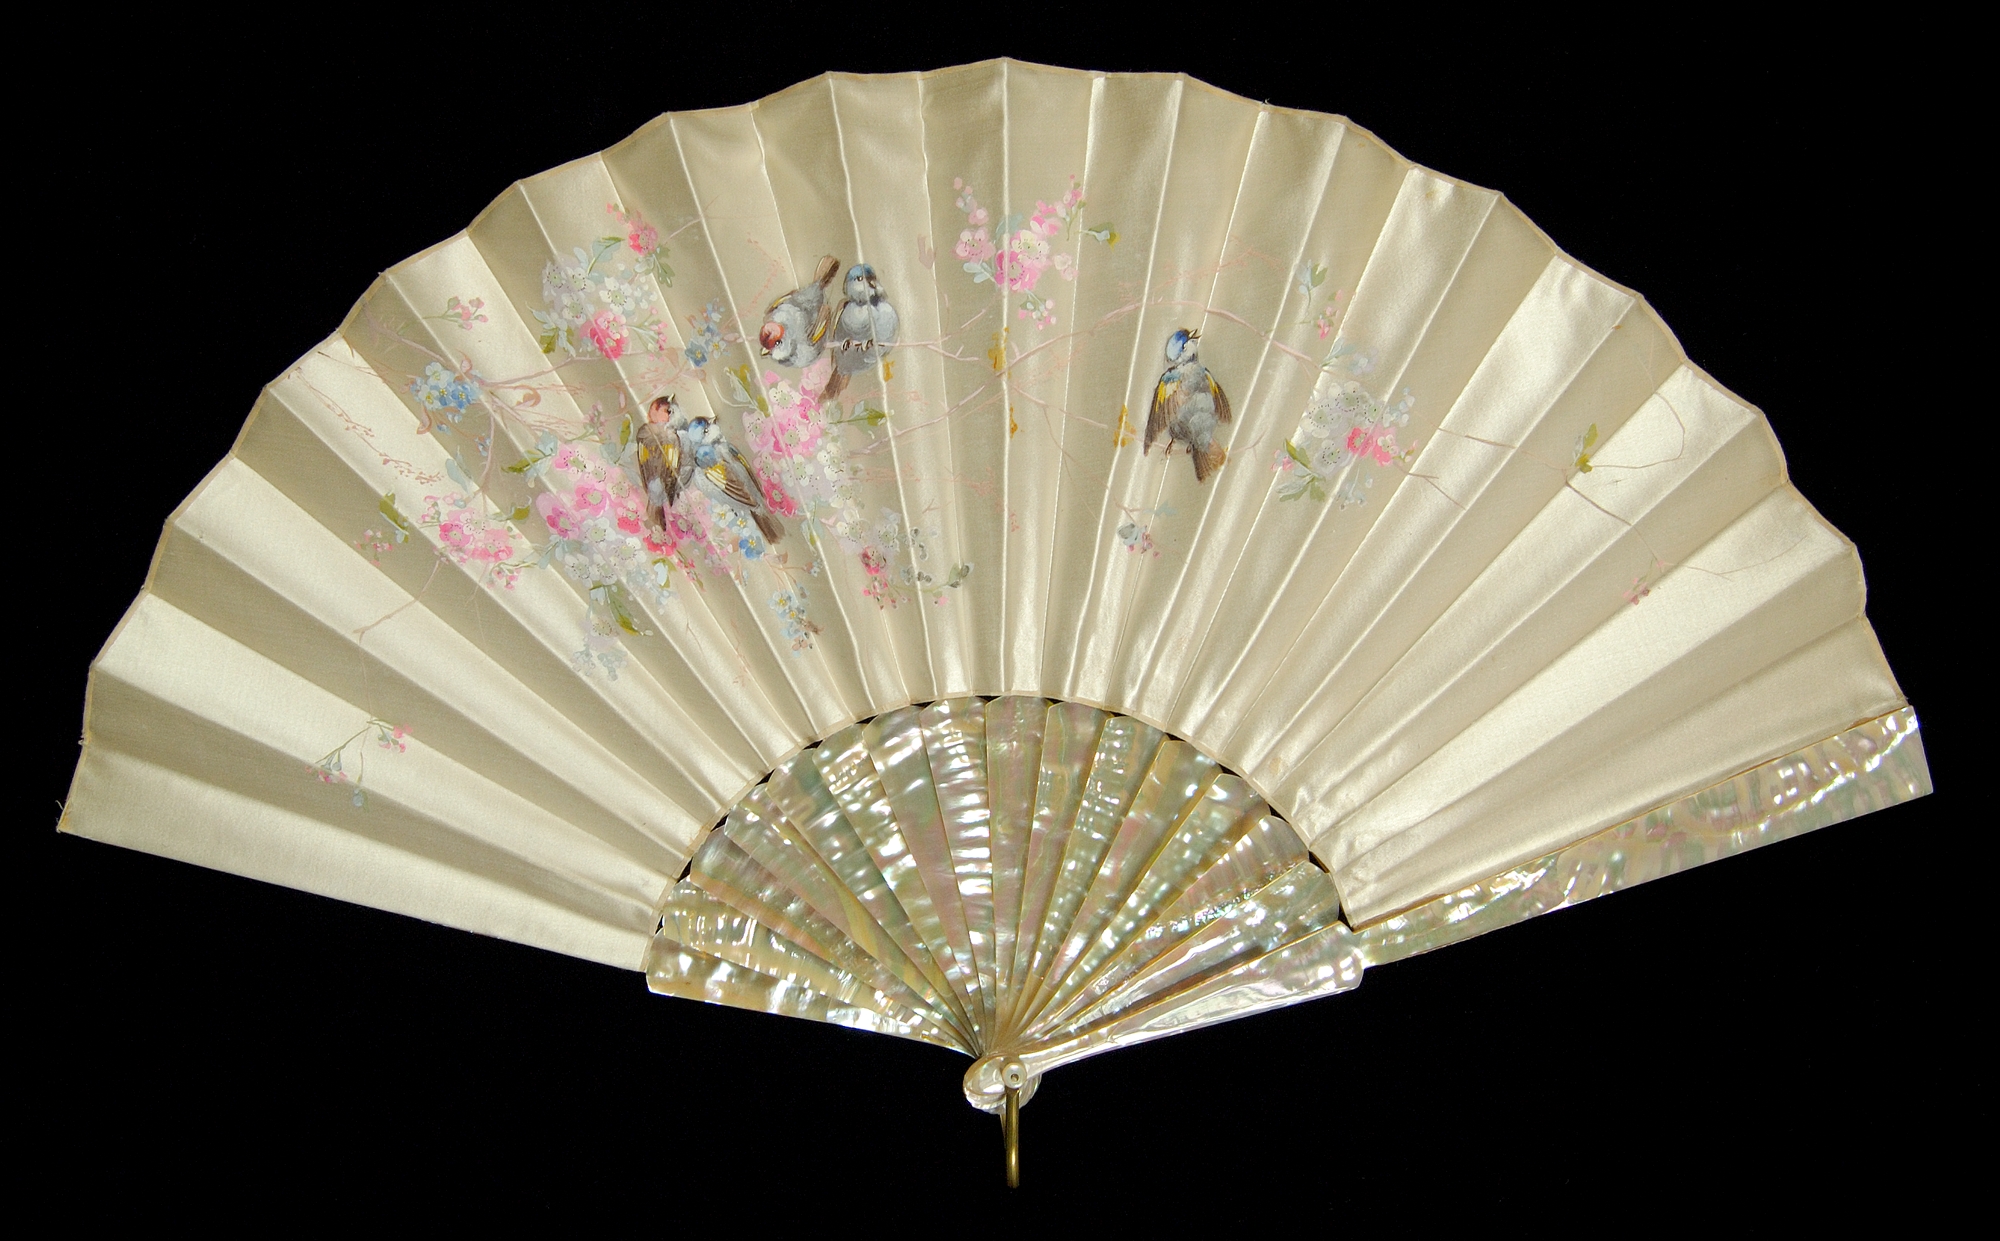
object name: fan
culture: american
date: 1880-1889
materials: metal, mother of pearl, silk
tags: birds,flowers